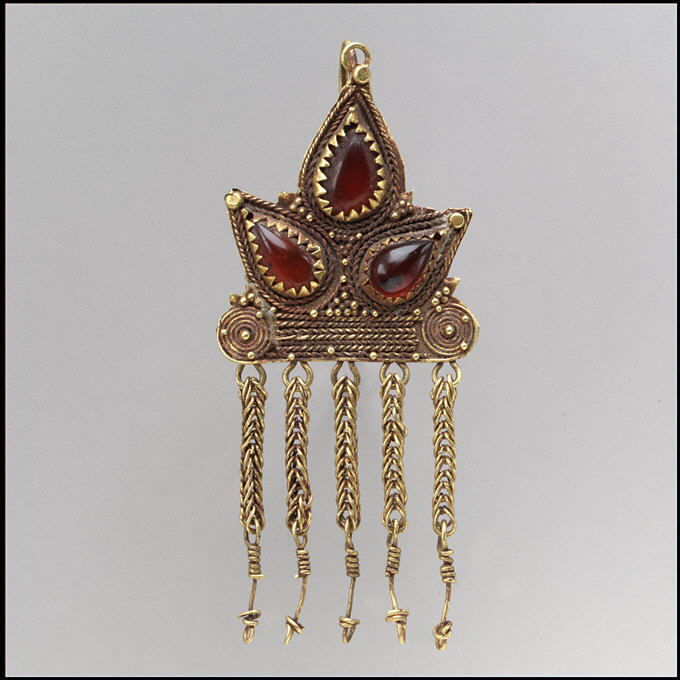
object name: earring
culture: sarmatian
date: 34-66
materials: gold, gemstone